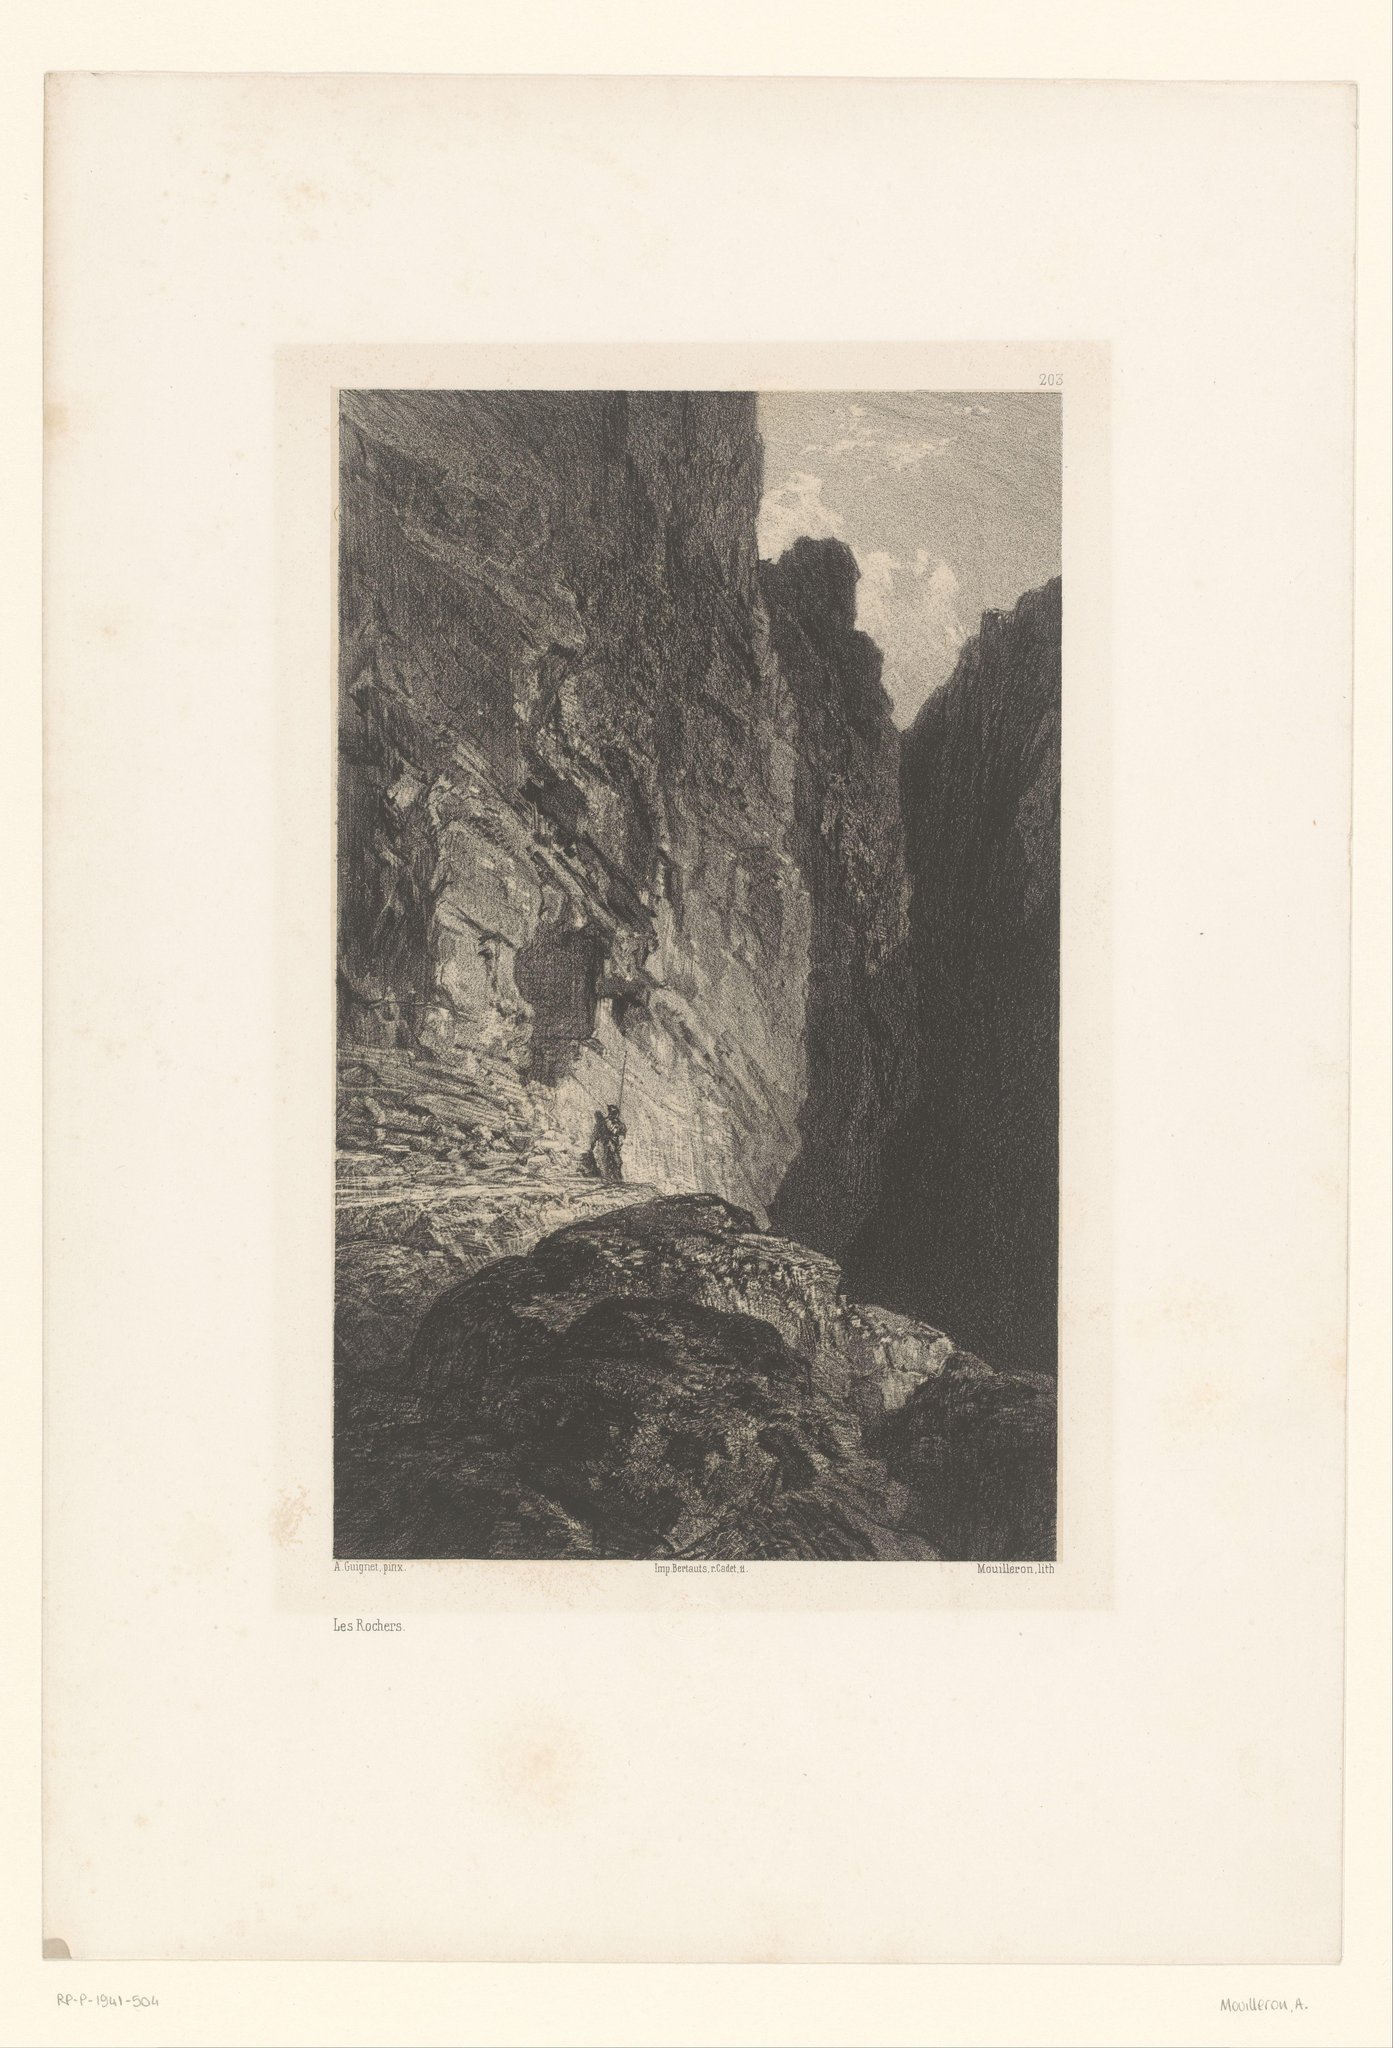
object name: print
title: Les artistes anciens et modernes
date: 1851-1862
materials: paper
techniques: tone lithography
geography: paris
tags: cave, grotto, guard duty, keeping sentry, rocks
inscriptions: check stamp: Lugt 36a, collector's mark: Lugt 2760, collector's mark: Lugt 2228